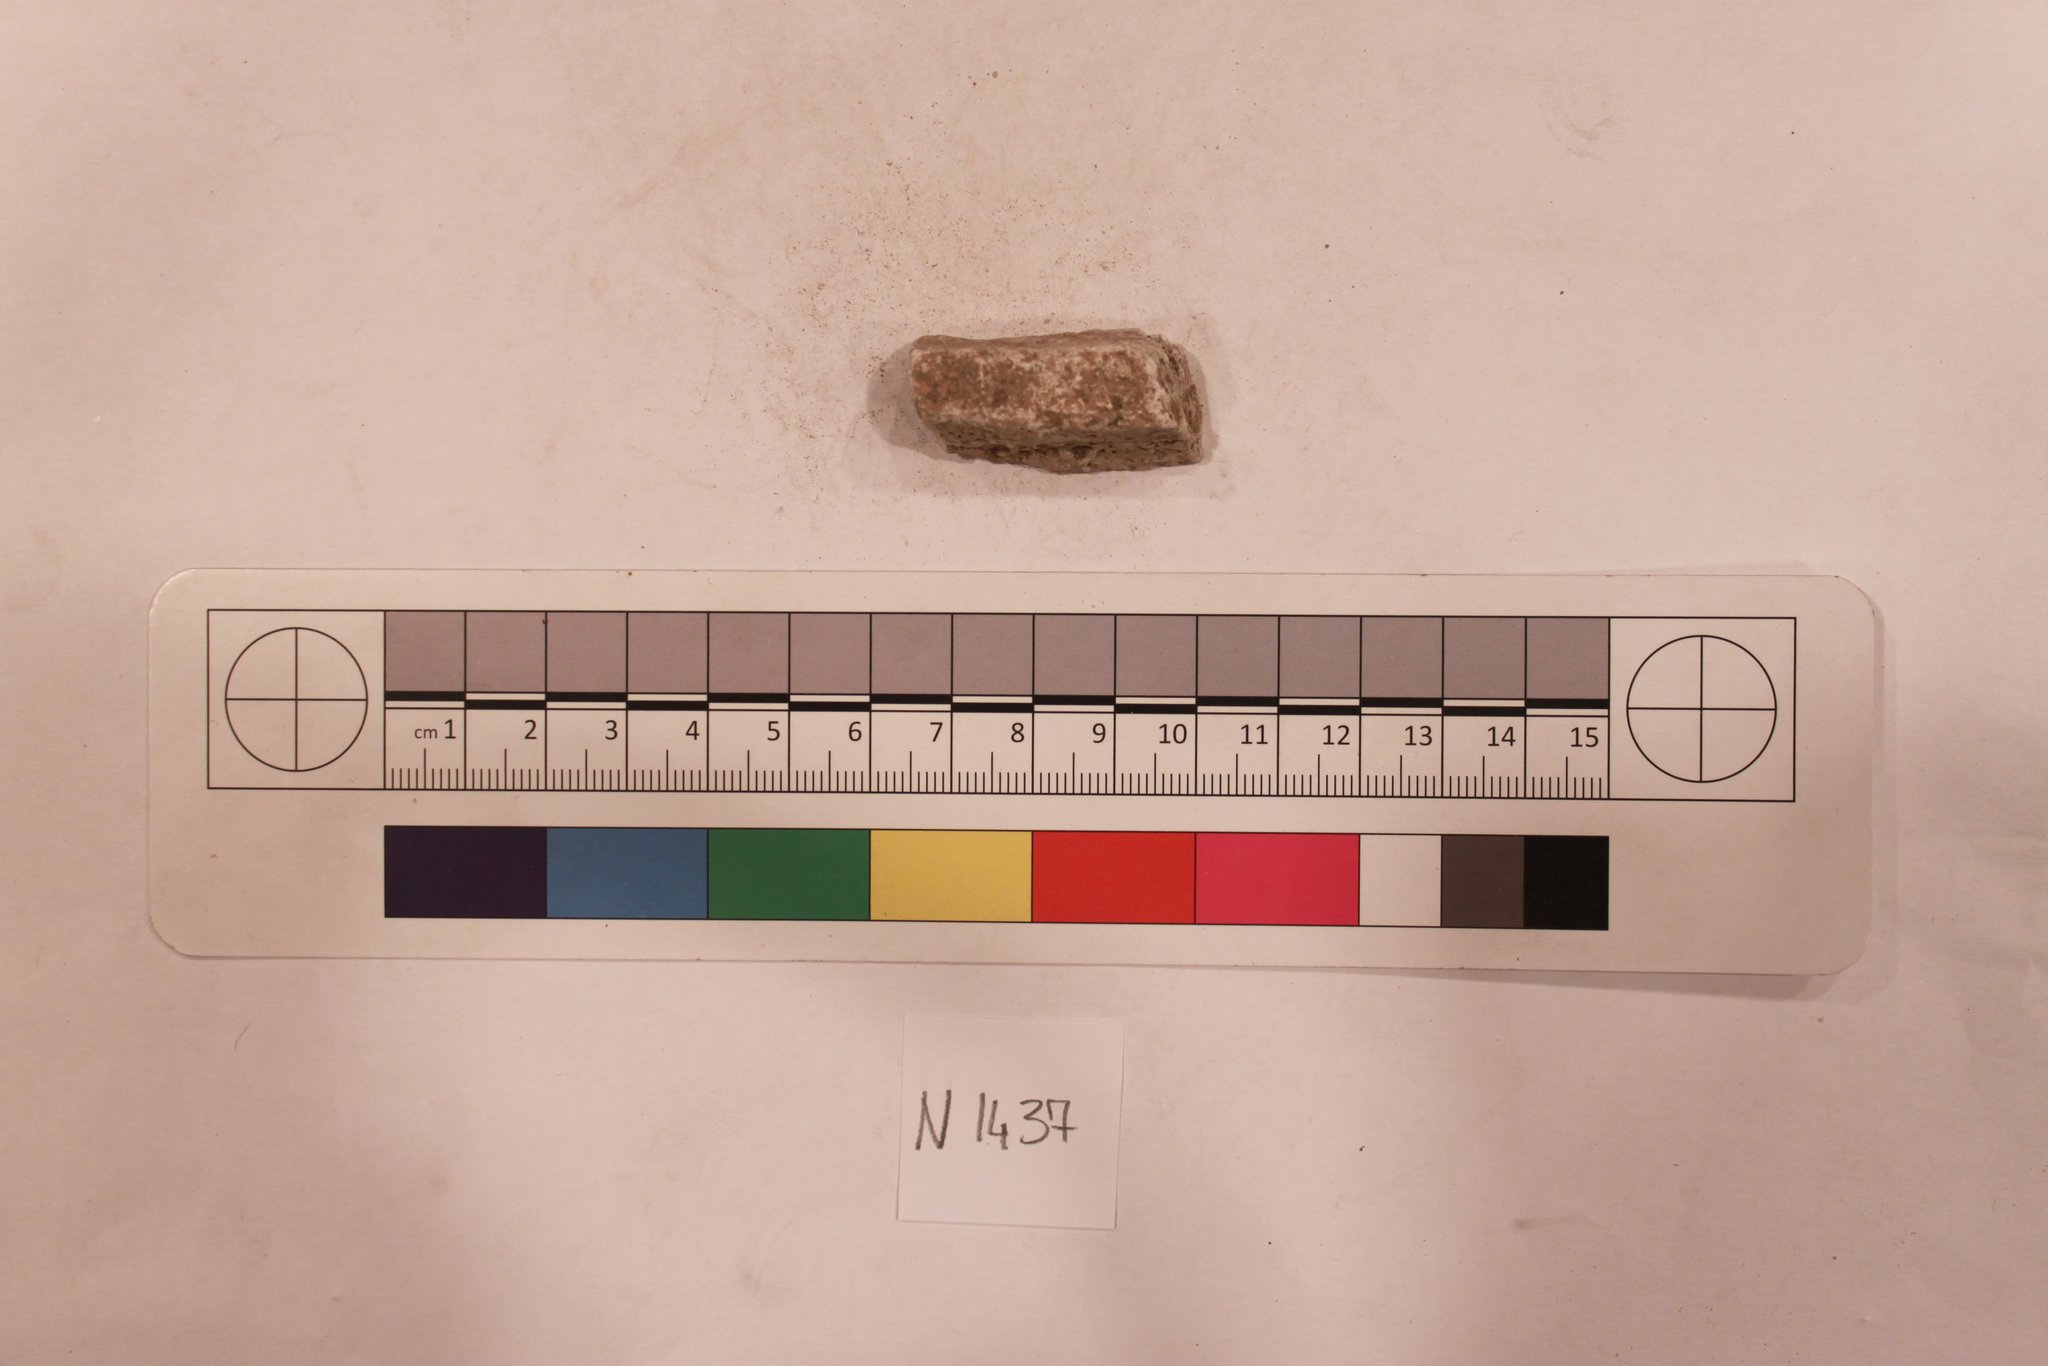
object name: fragment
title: Stucco Fragment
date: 701-1200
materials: plaster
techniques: carving, painting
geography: iran